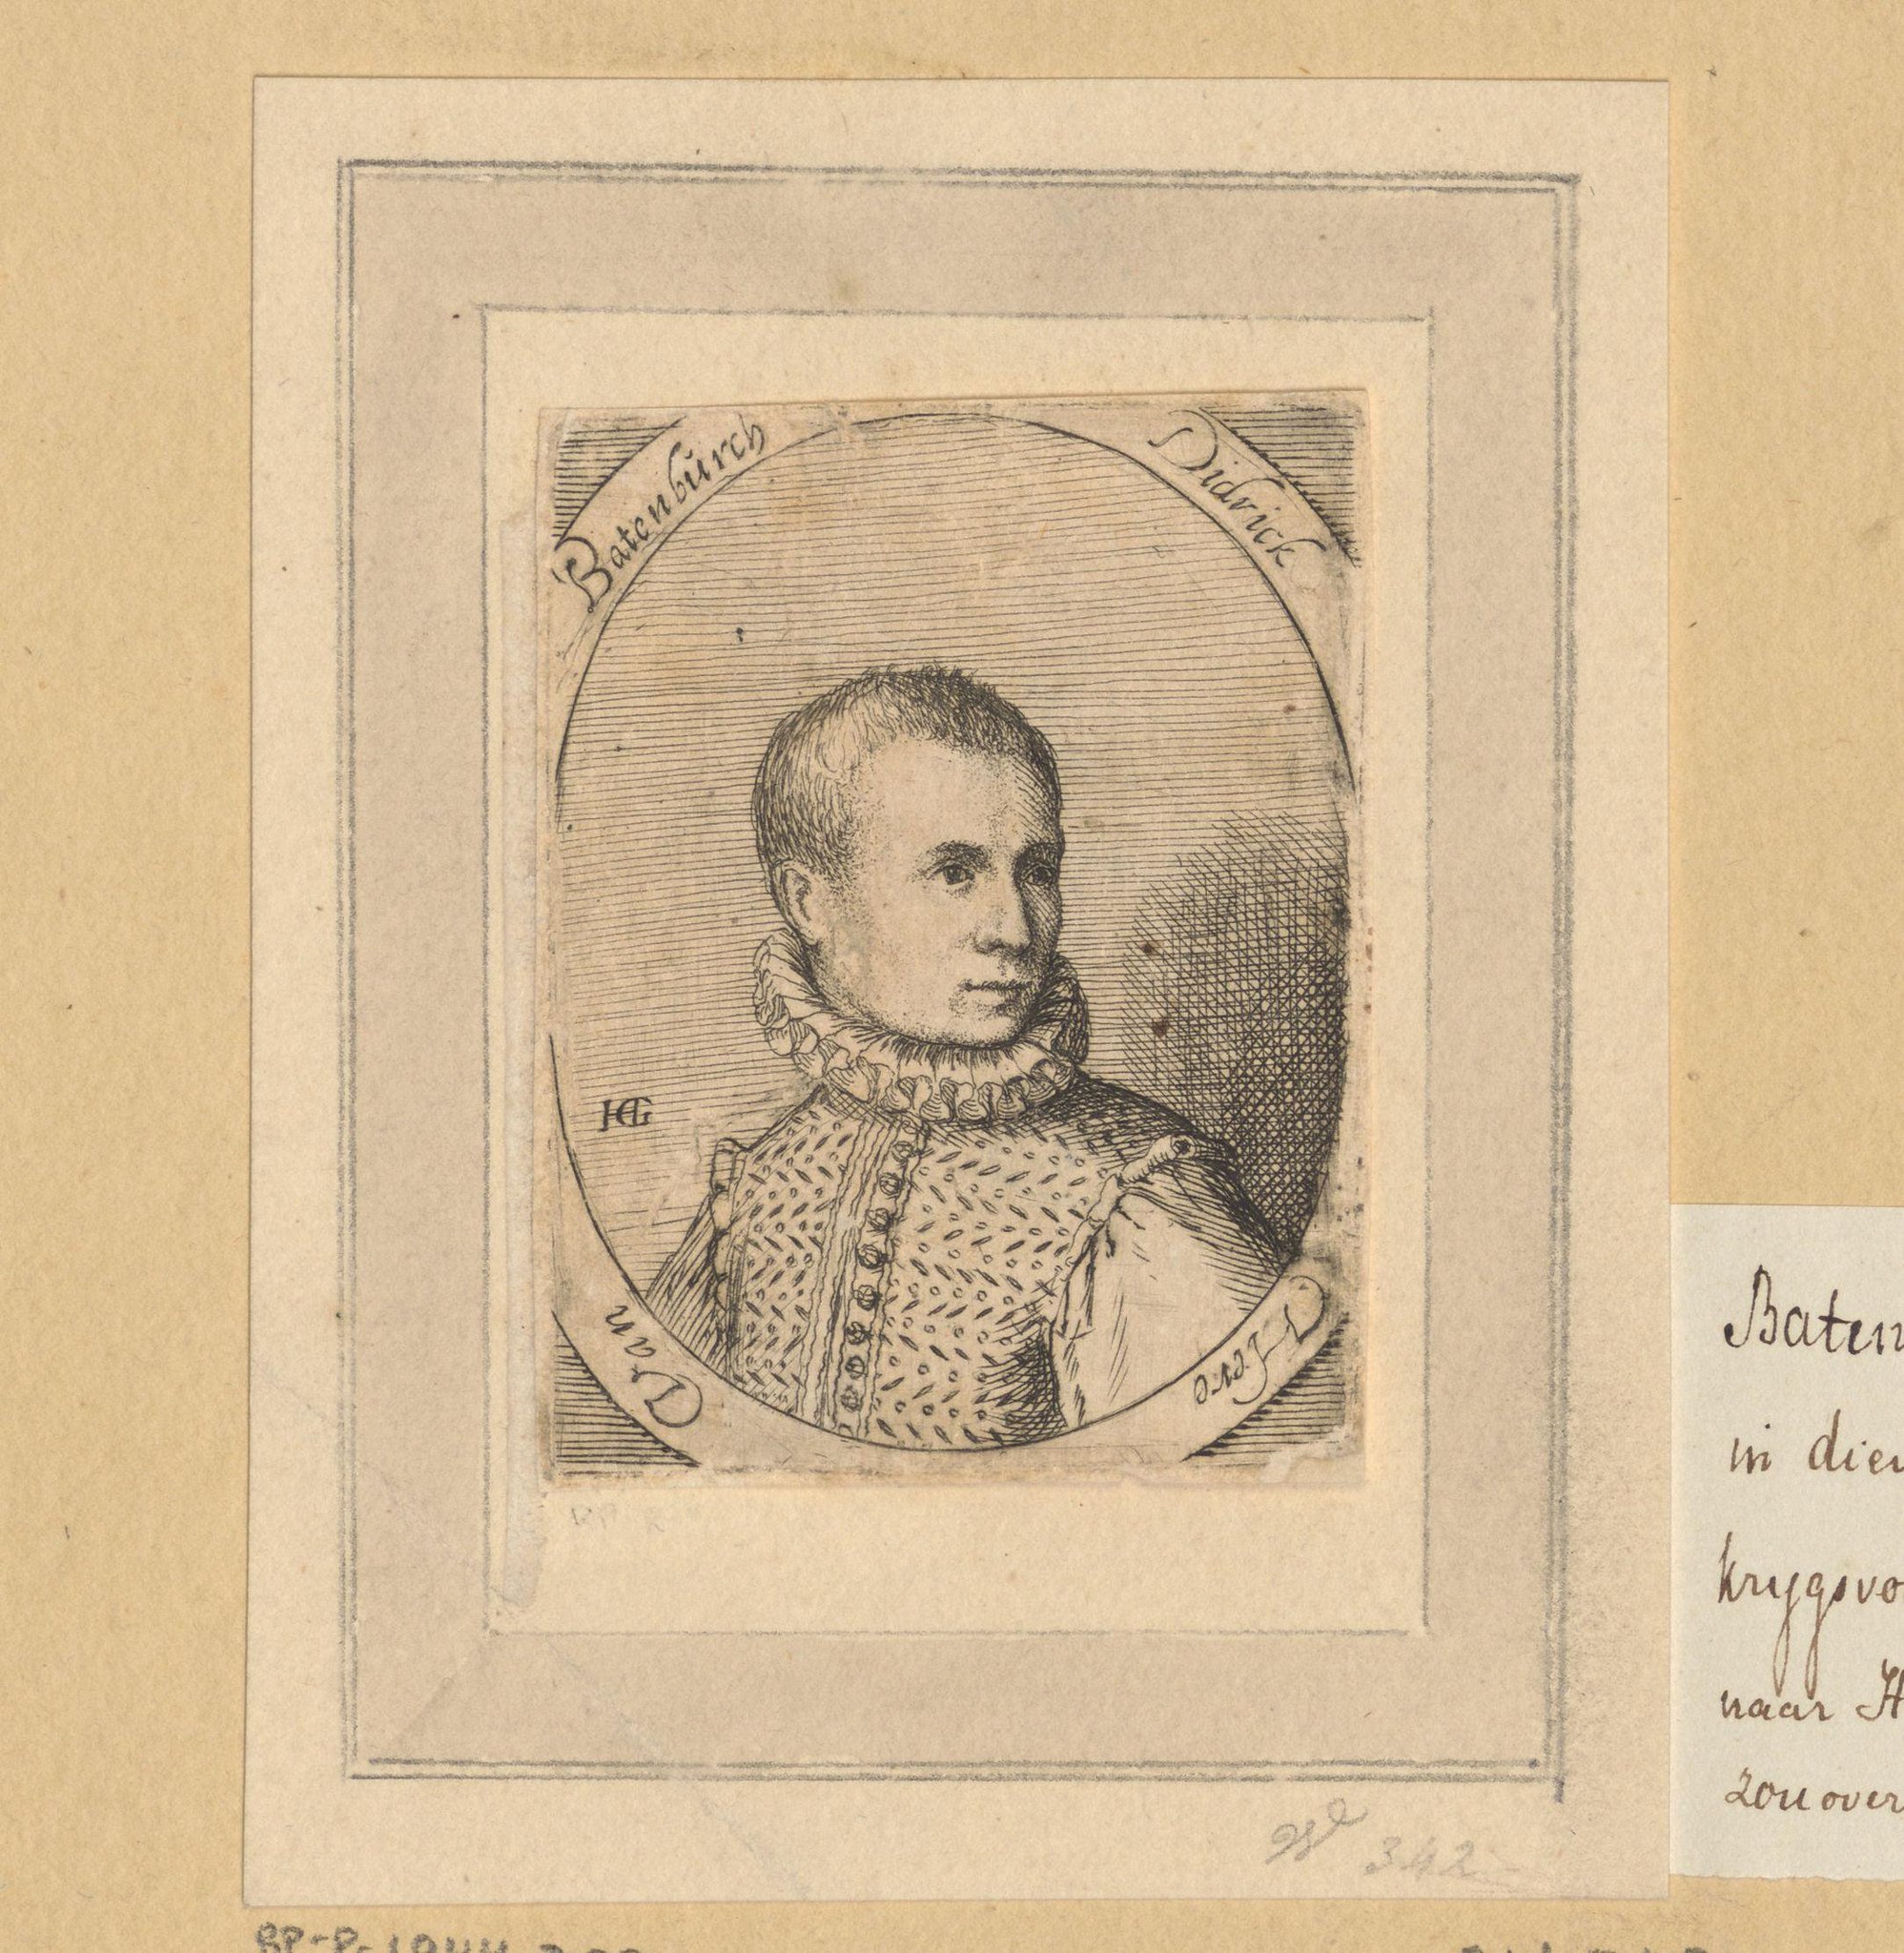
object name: print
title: Portret van Diederik van Bronckhorst-Batenburg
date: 1650-1749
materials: paper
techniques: etching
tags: brussels, historical persons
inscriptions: collector's mark: Lugt 2228, collector's mark: Lugt 963, inscription: ‘Diderick van Batenburgh ontwijkt deeze lande [...] door Alva en zijn bloedraat op een schavot onthalst 1 junij 1658.’